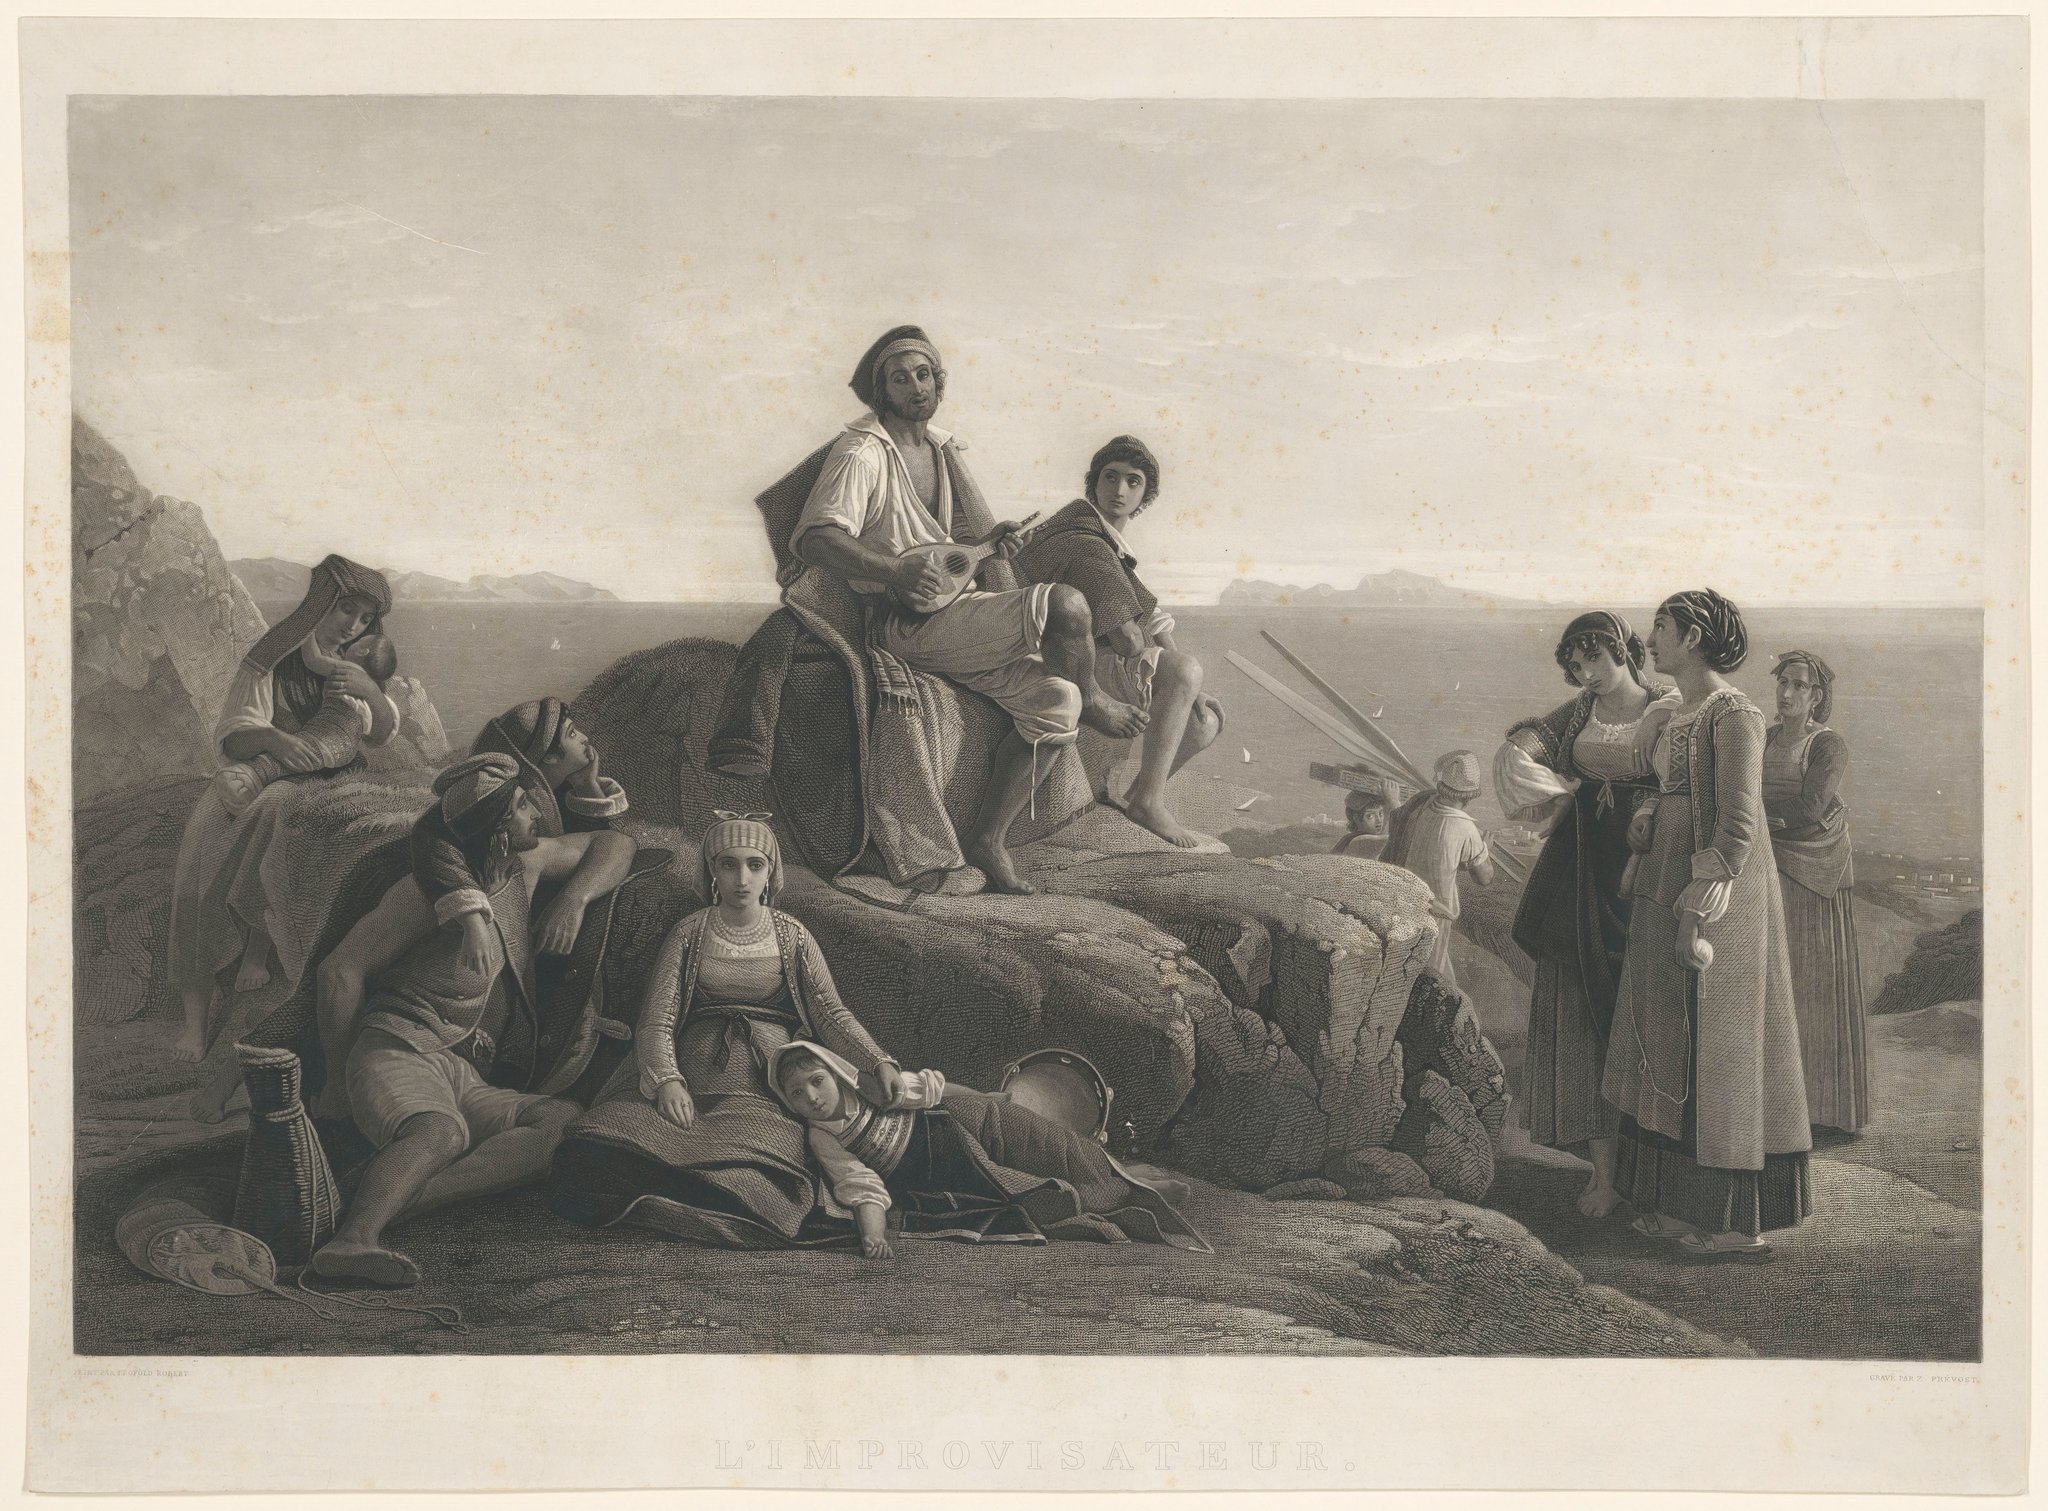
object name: print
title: L'improvisateur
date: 1807-1861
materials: paper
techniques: aquatint, roulette, engraving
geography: france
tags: musician at work - cc - out of doors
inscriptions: collector's mark: Lugt 2228